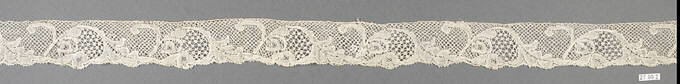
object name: strip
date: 1701-1800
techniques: lace